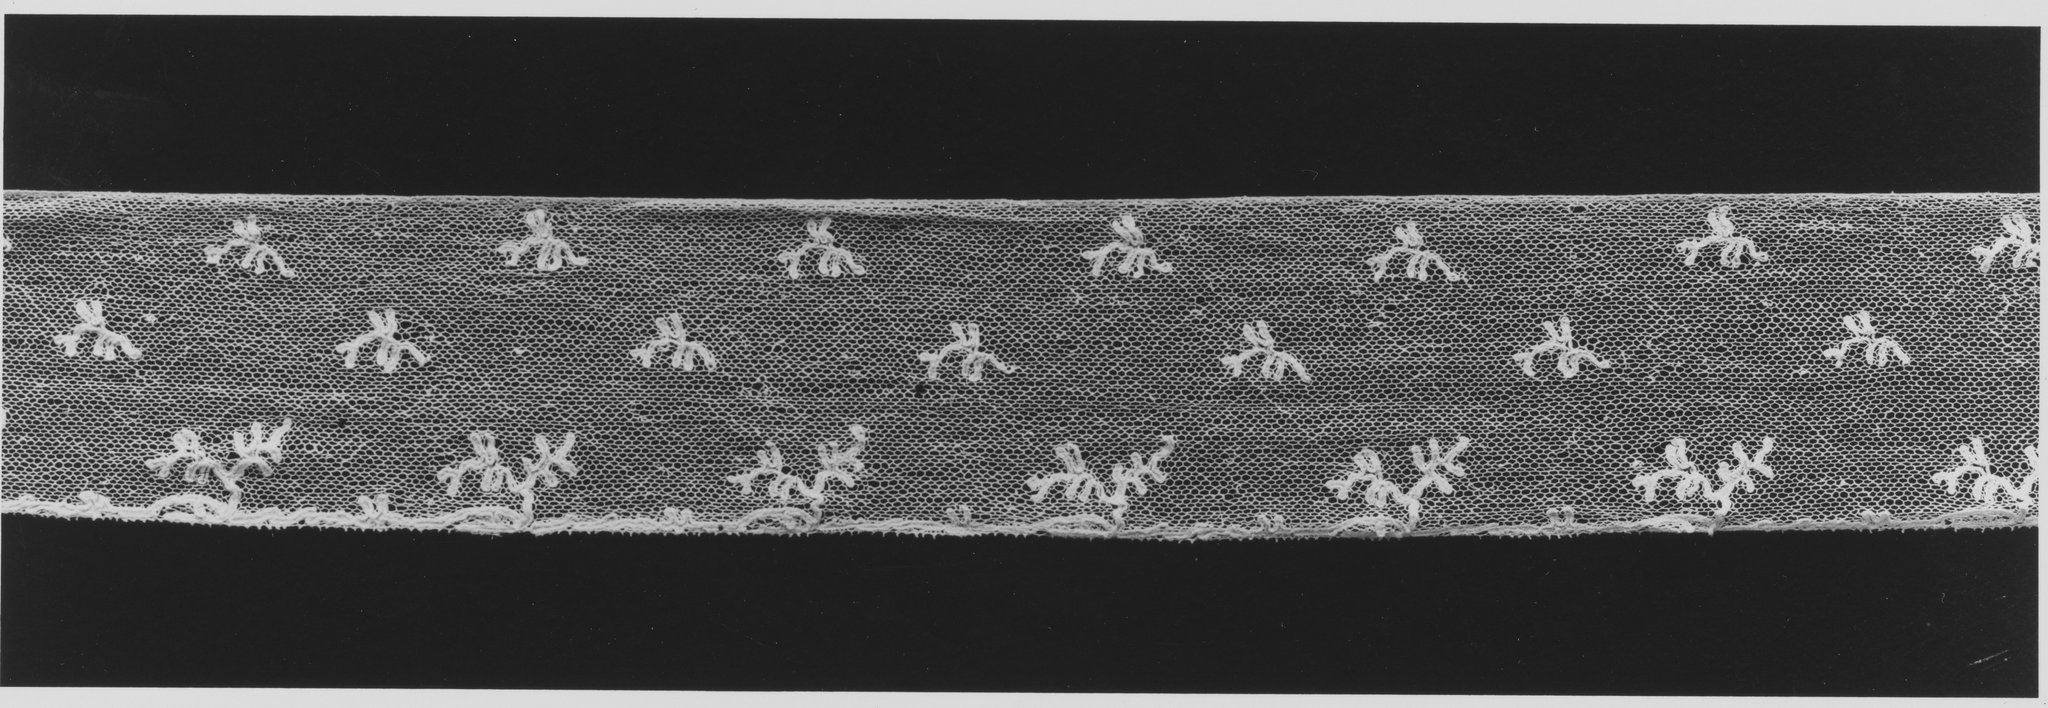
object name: piece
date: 1701-1900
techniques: lace